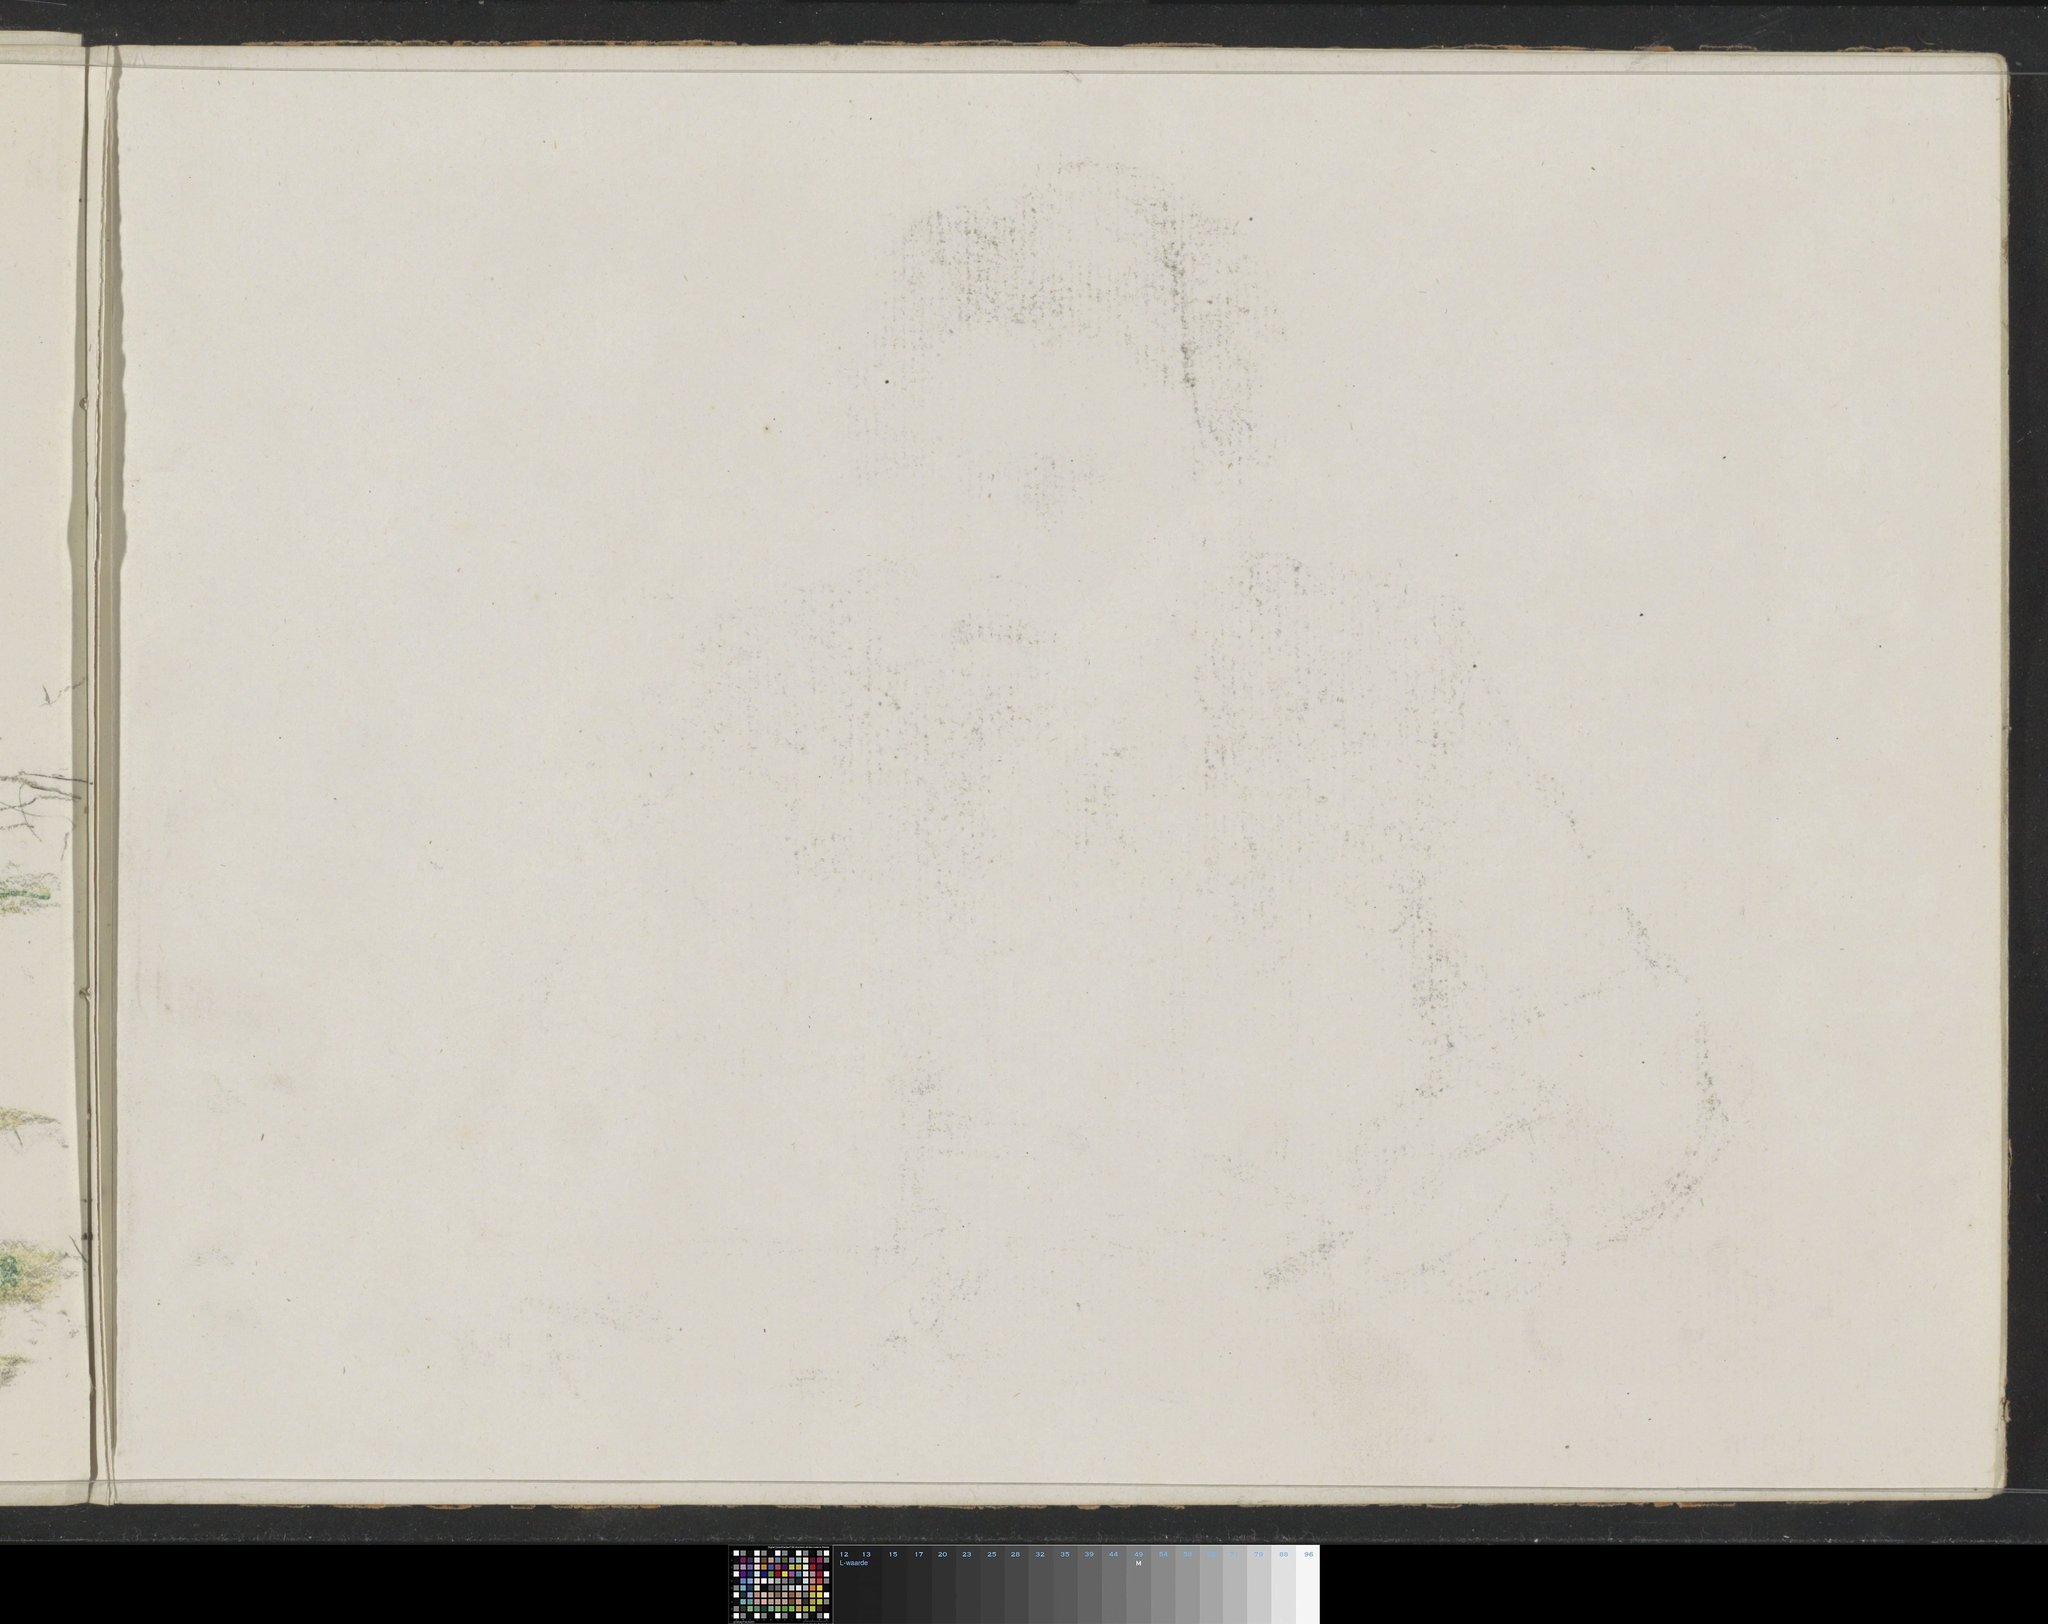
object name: sketchbook leaf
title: Abklatsch van een krijttekening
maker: ferdinand oldewelt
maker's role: draughtsman, print maker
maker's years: 1857-1935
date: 1904-1912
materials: paper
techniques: printmaking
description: De tekening van een vrouw die met haar handen op een tafel ligt is niet langer aanwezig in het schetsboek. Blad 27 recto uit een schetsboek met 27 bladen.